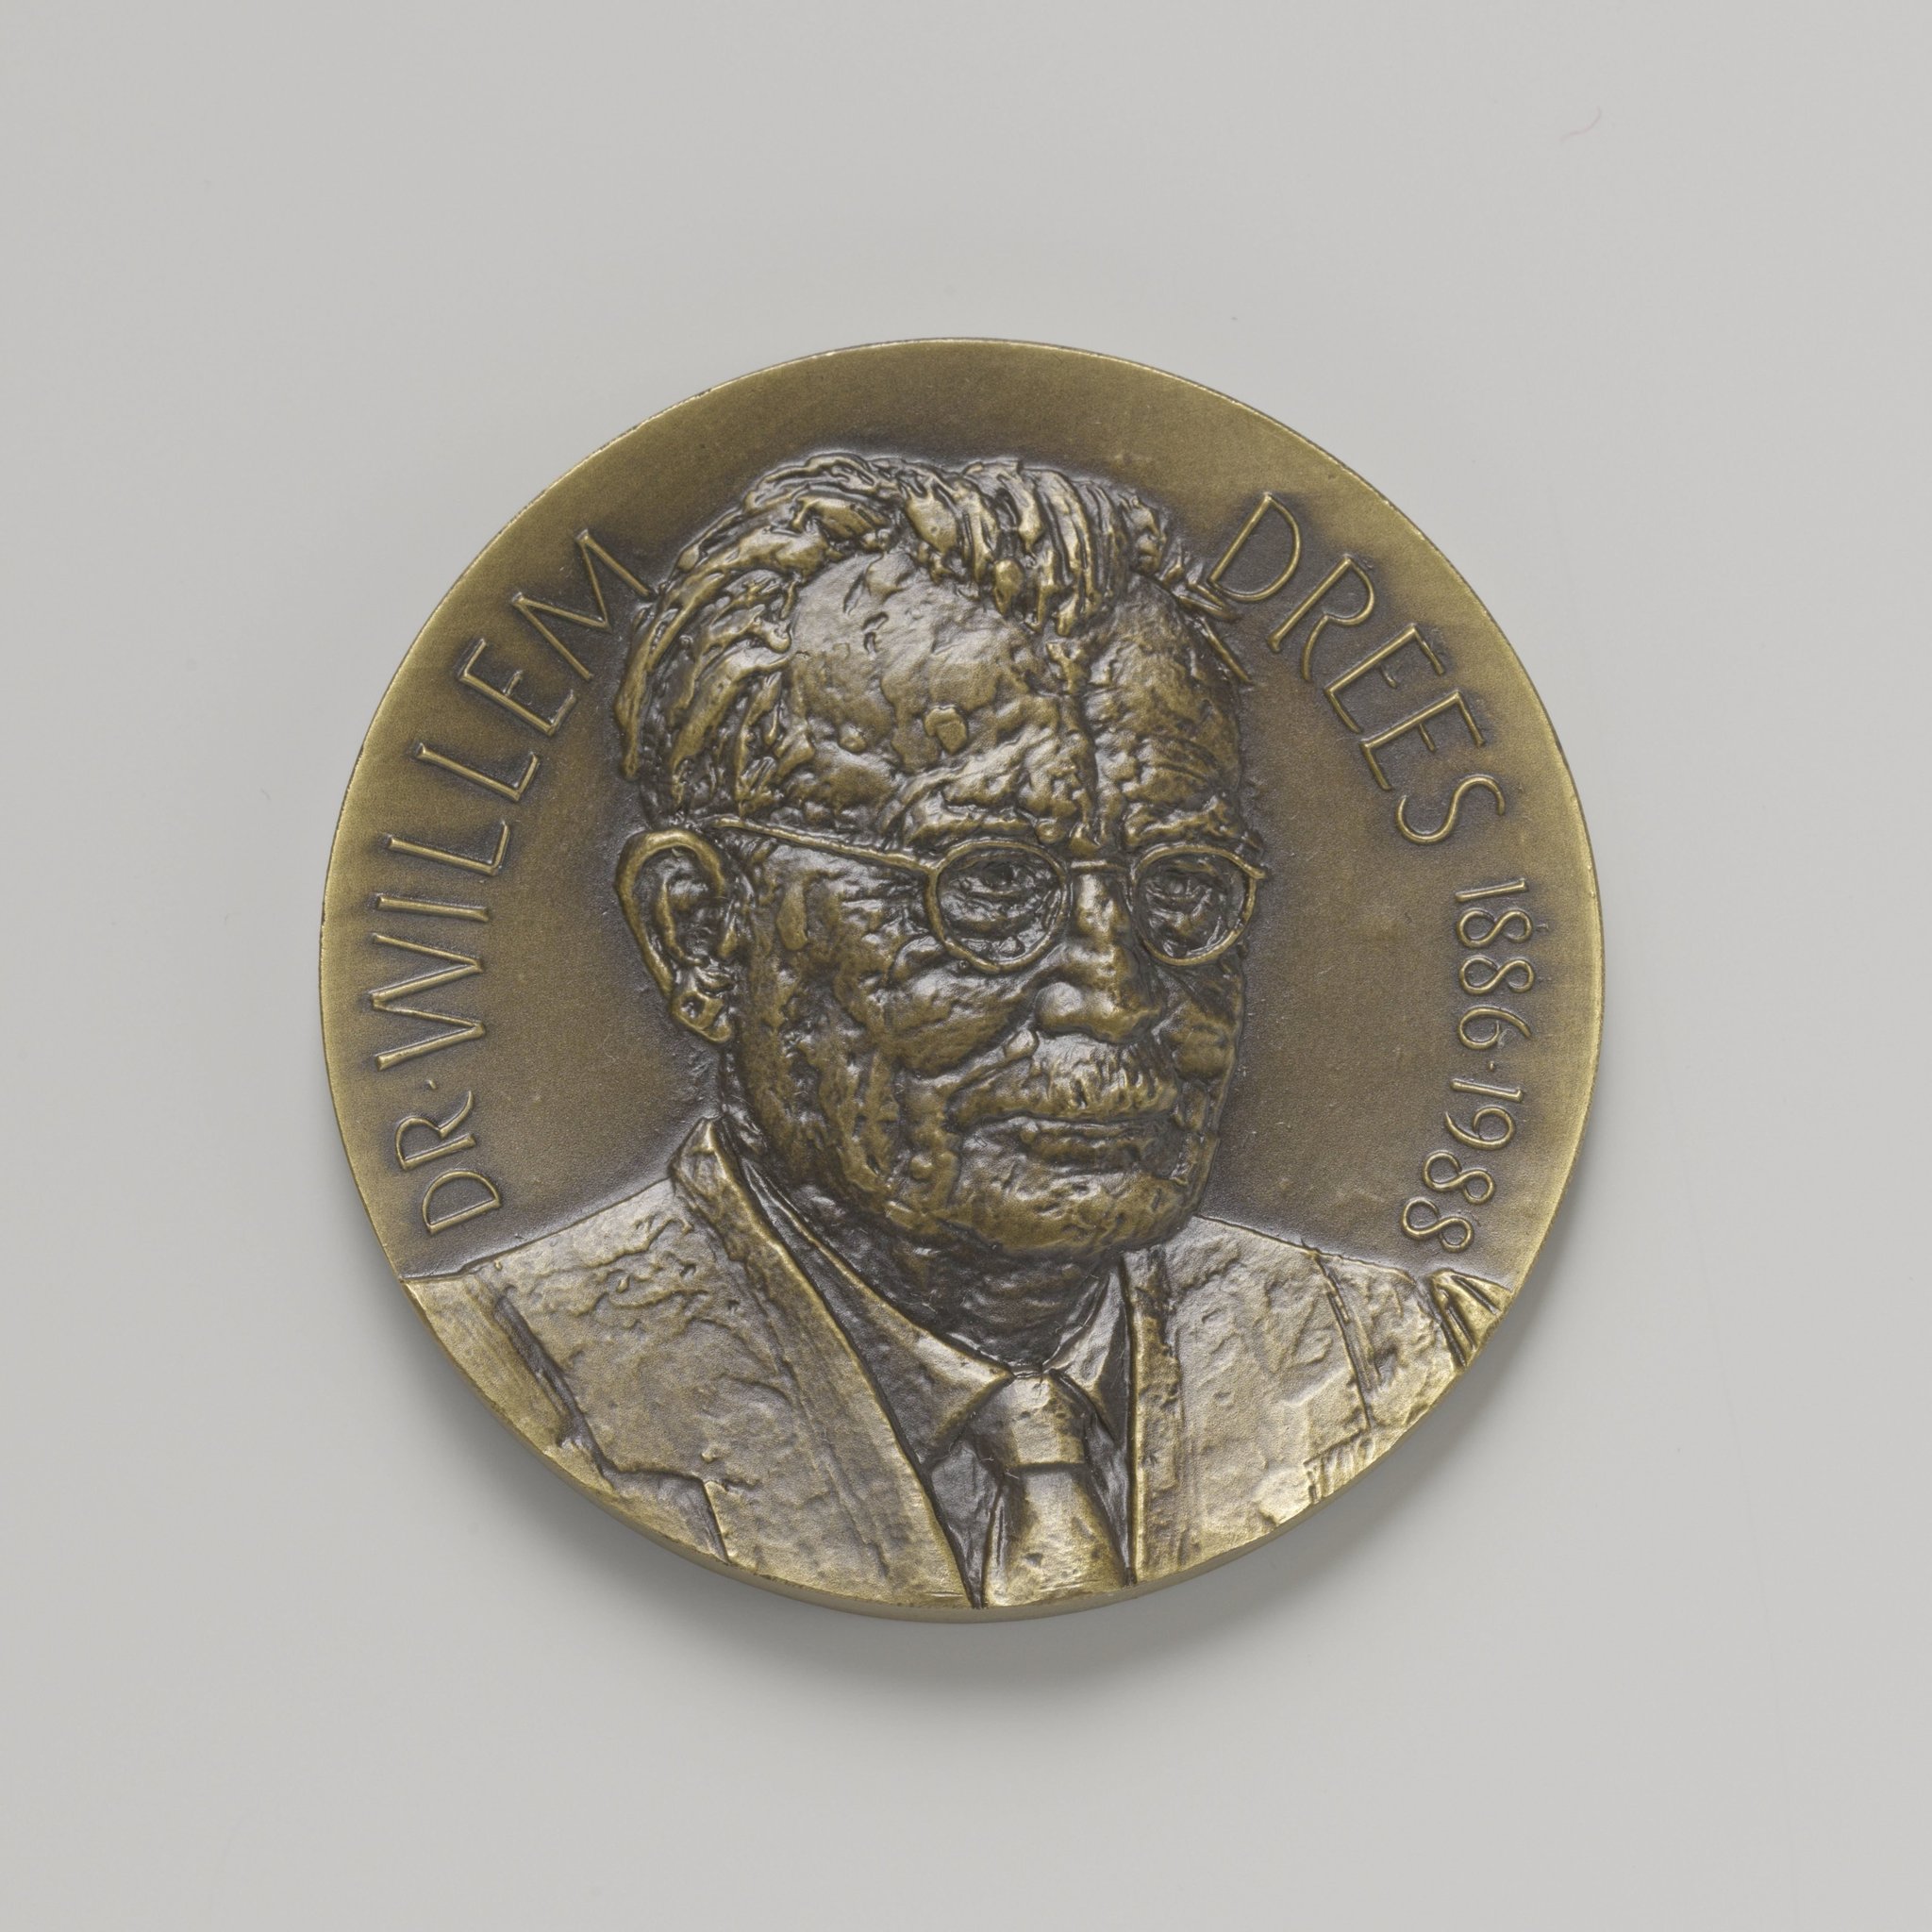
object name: overlijdenspenning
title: Overlijden van Dr. Willem Drees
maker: Anonymous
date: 1988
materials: bronze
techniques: relief, striking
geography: netherlands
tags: amsterdam, the hague, willem drees, netherlands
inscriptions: inscription: ‘DR. WILLEM DREES 1886-1988’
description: Bronzen penning. Voorzijde: portret van Drees met omschrift. Keerzijde: een levensboom en merk.